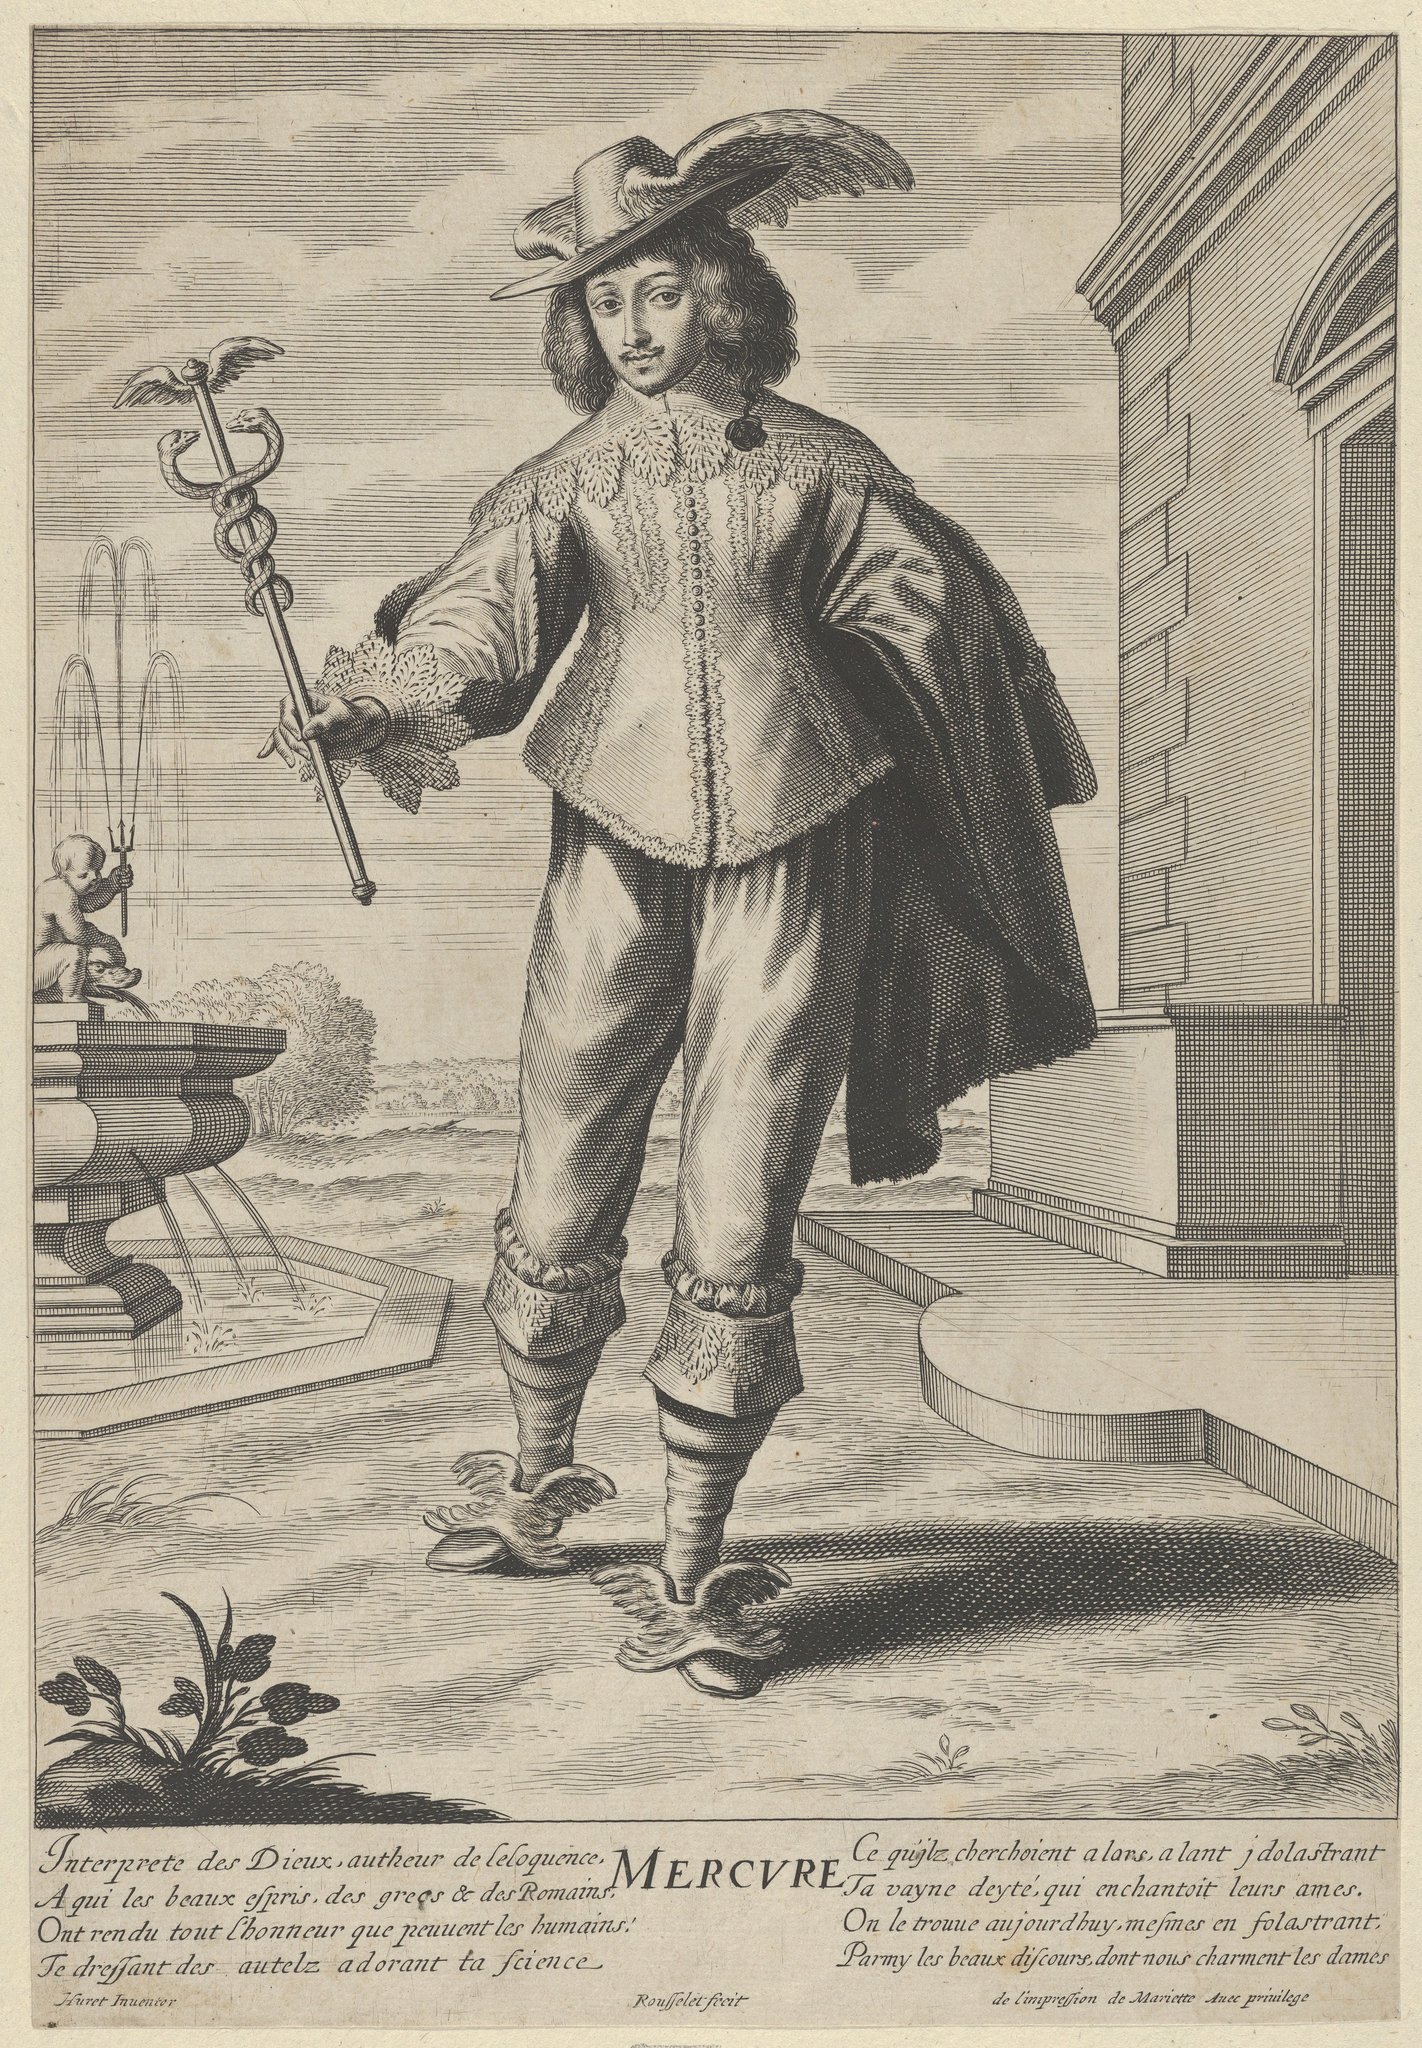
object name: print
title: Taste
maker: gilles rousselet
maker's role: artist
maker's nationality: french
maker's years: 1614-1686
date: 1601-1700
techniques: engraving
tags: men,portraits